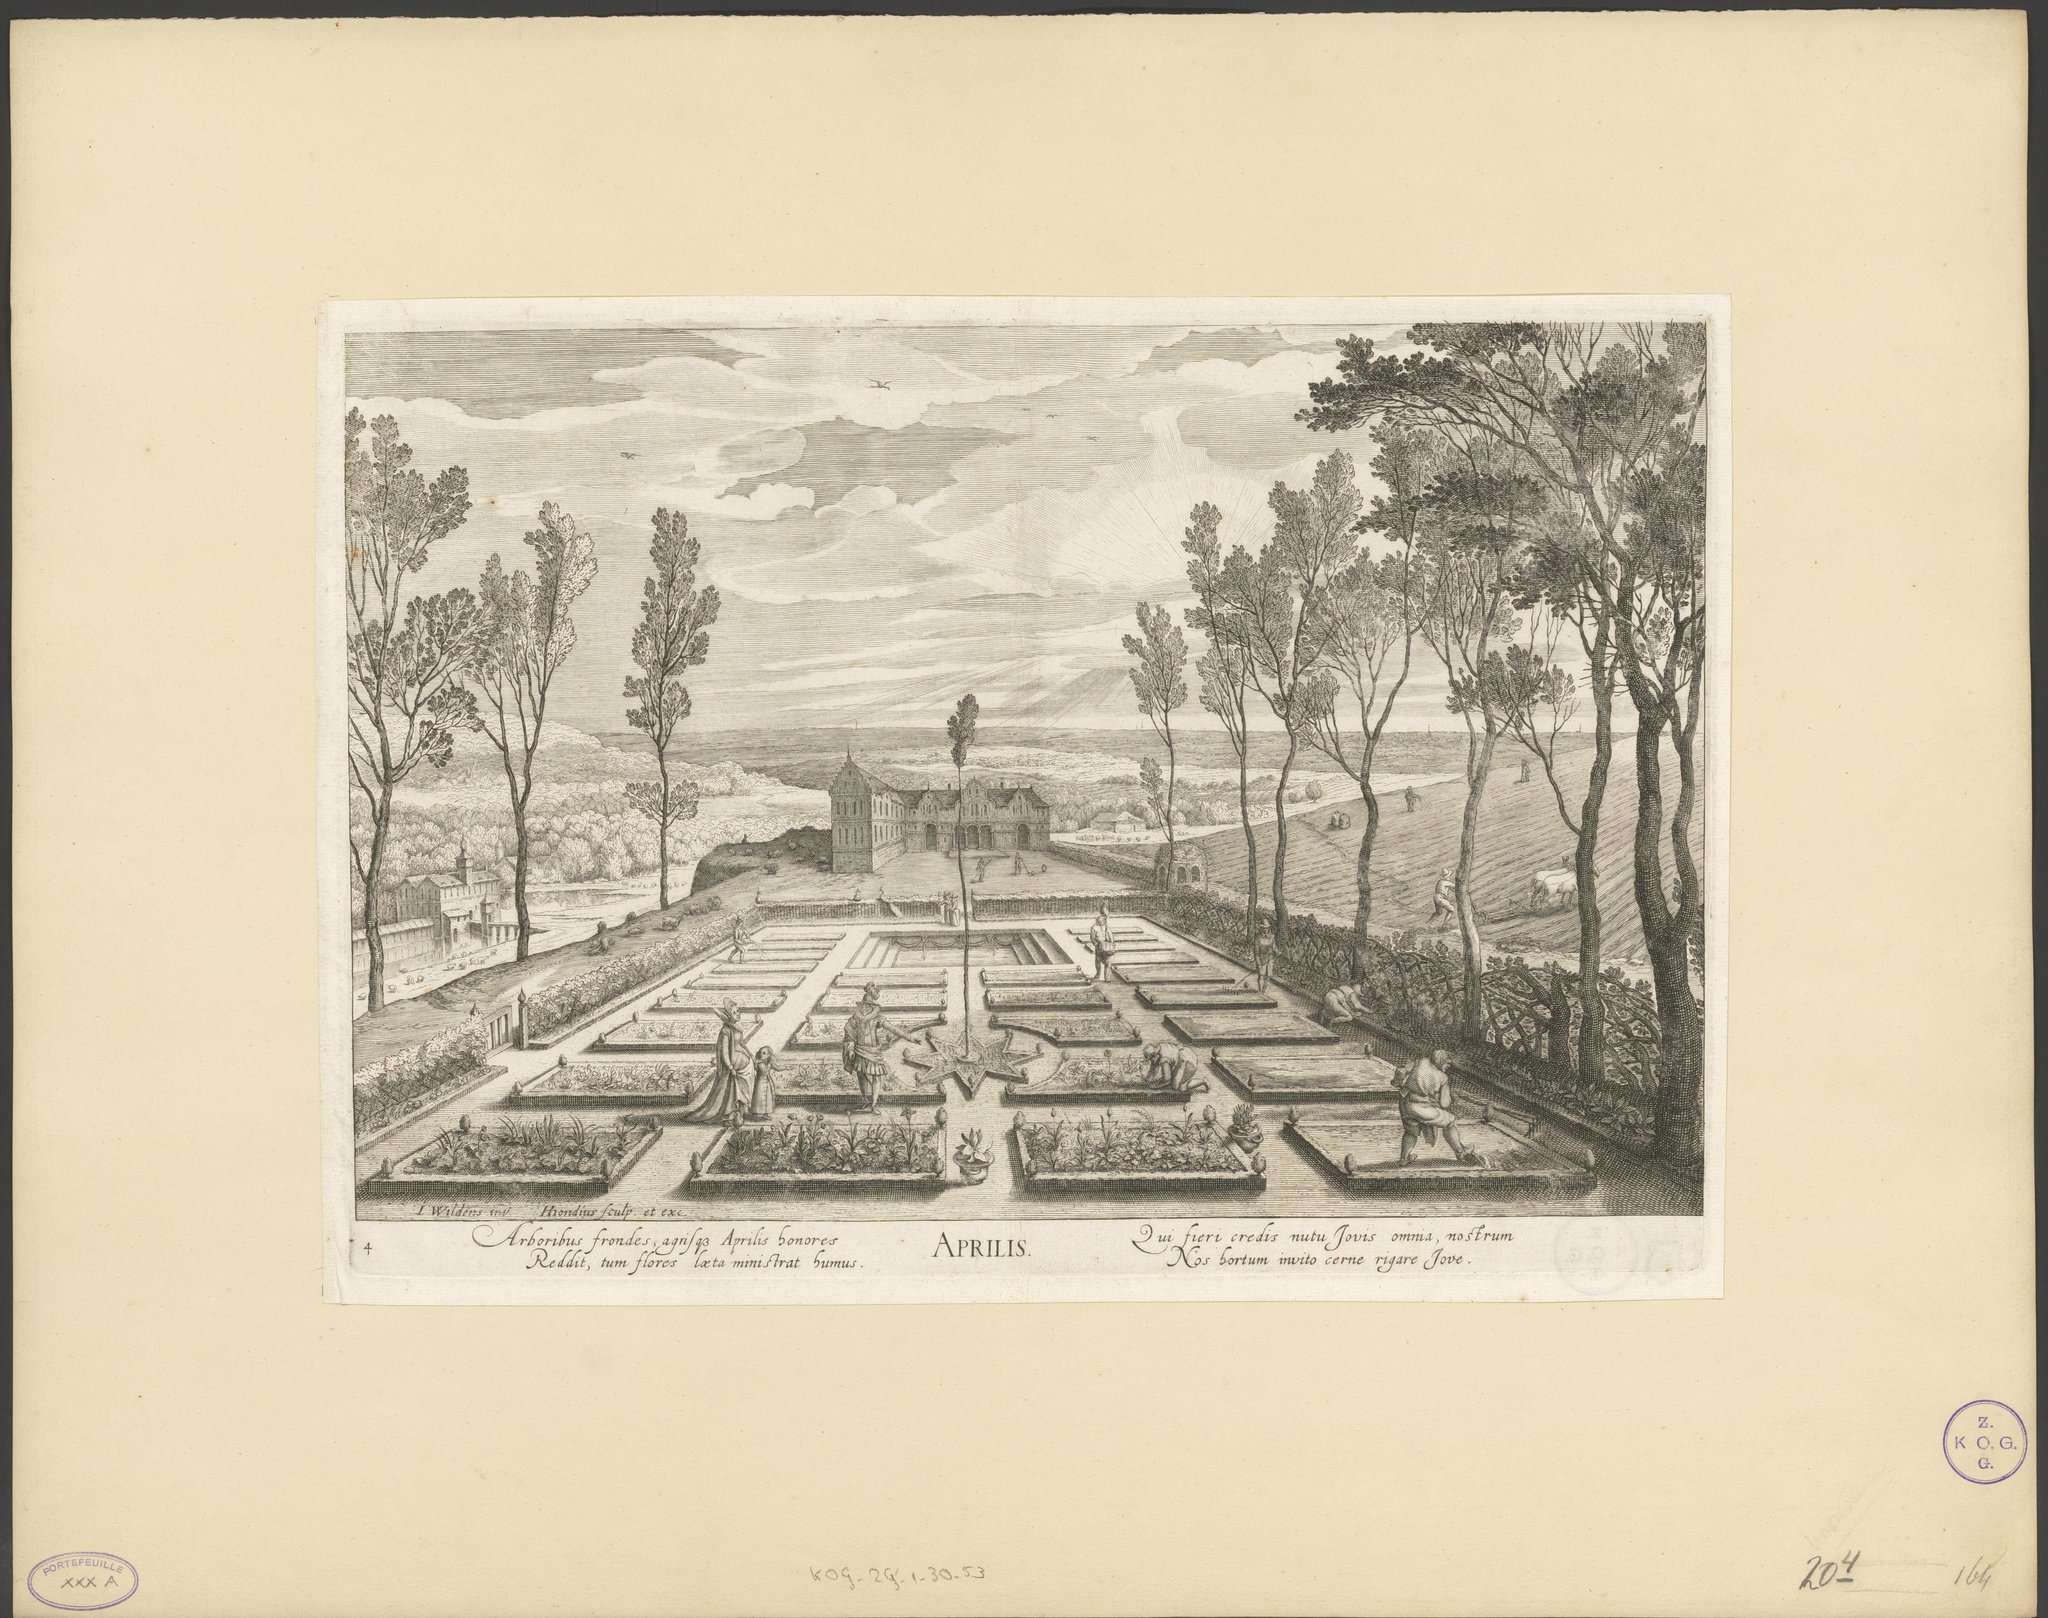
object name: print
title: Aprilis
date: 1614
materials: paper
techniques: engraving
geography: the hague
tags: landscape symbolizing april, april and its 'labours', garden, gardening, ploughing, seasons of the year represented by still lifes of flowers and/or fruits (+ garden representing seasons and months)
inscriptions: stamp, collector's mark: Lugt 1641, collector's mark: Lugt 1641, stamp: 963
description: Symmetrisch aangelegde Franse tuin op de voorgrond. Kasteel op de achtergrond. In de tuin die is opgedeeld in bloemperken, lopen een dame en een heer met kind en zijn tuinlieden aan het werk. Rechts wordt het land geploegd. Onder de voorstelling een tekst in het Latijn. Prent uit een serie van de twaalf maanden. Onderaan een vierregelig vers in twee kolommen in het Latijn. Onderwerpsrubrieken binnen de Atlas Zeden en Gewoonten: Zeden en Gewoonten in engeren zin. Volksleven. Zinnebeeldige voorstellingen uit het volkleven op serieprenten. Maanden en diversen (allegorieën).